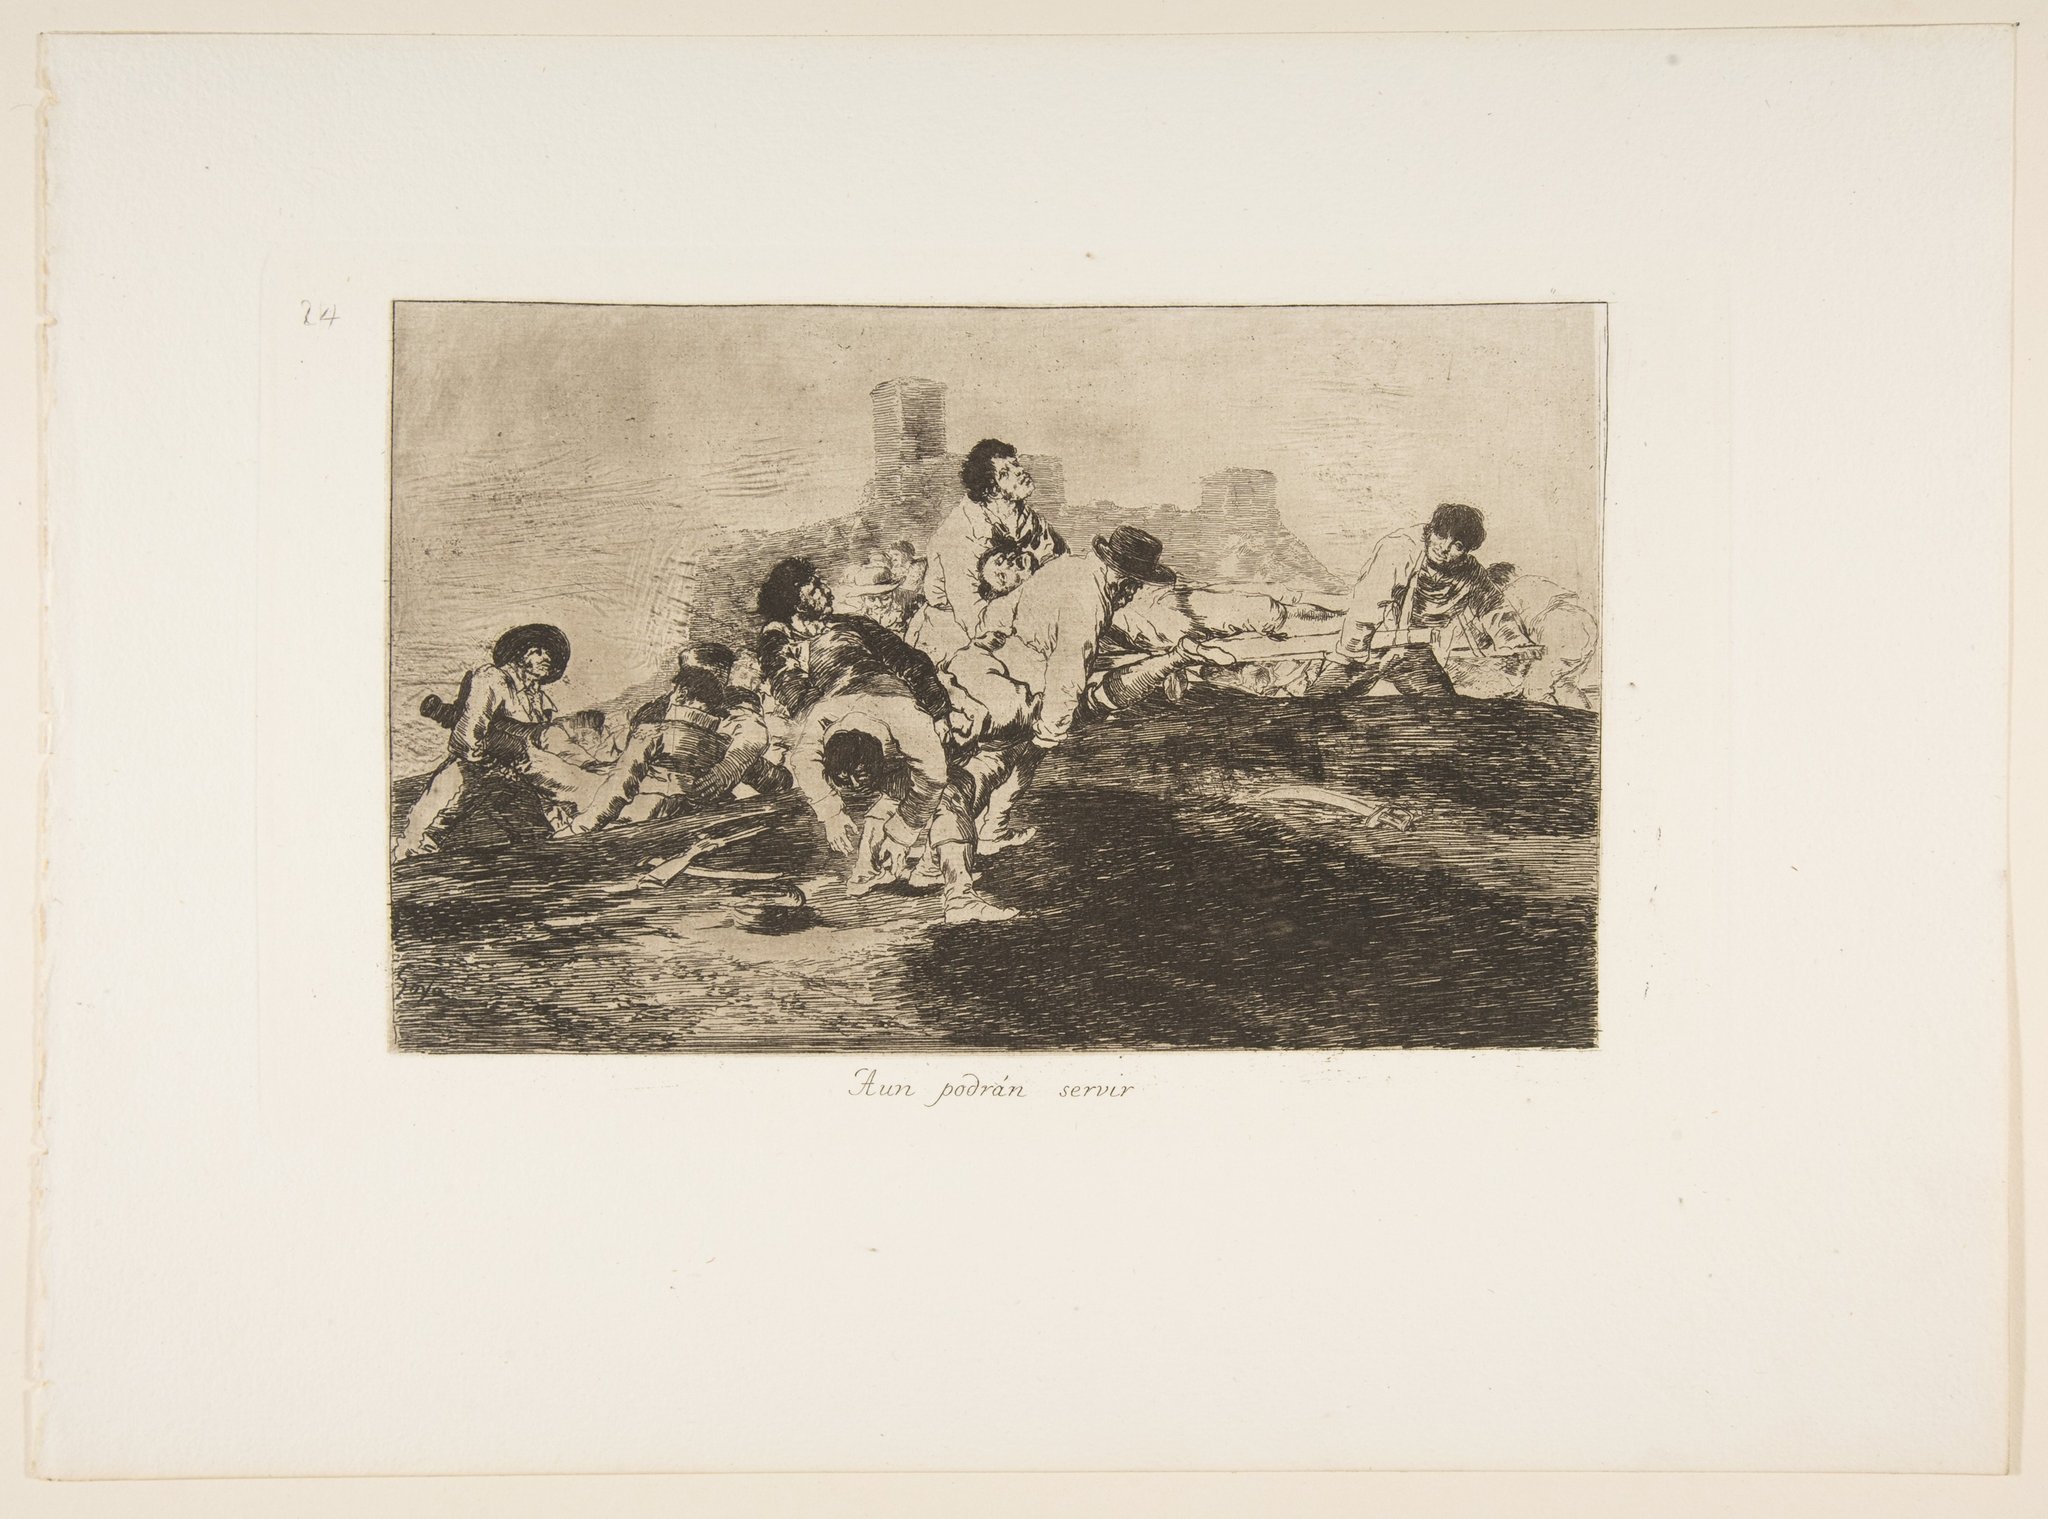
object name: print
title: Plate 24 from "The Disasters of War" (Los Desastres de la Guerra): 'They can still be of use' (Aun podrán servir)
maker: goya (francisco de goya y lucientes)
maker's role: artist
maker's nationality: spanish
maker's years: 1746-1828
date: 1810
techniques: etching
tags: suffering,men